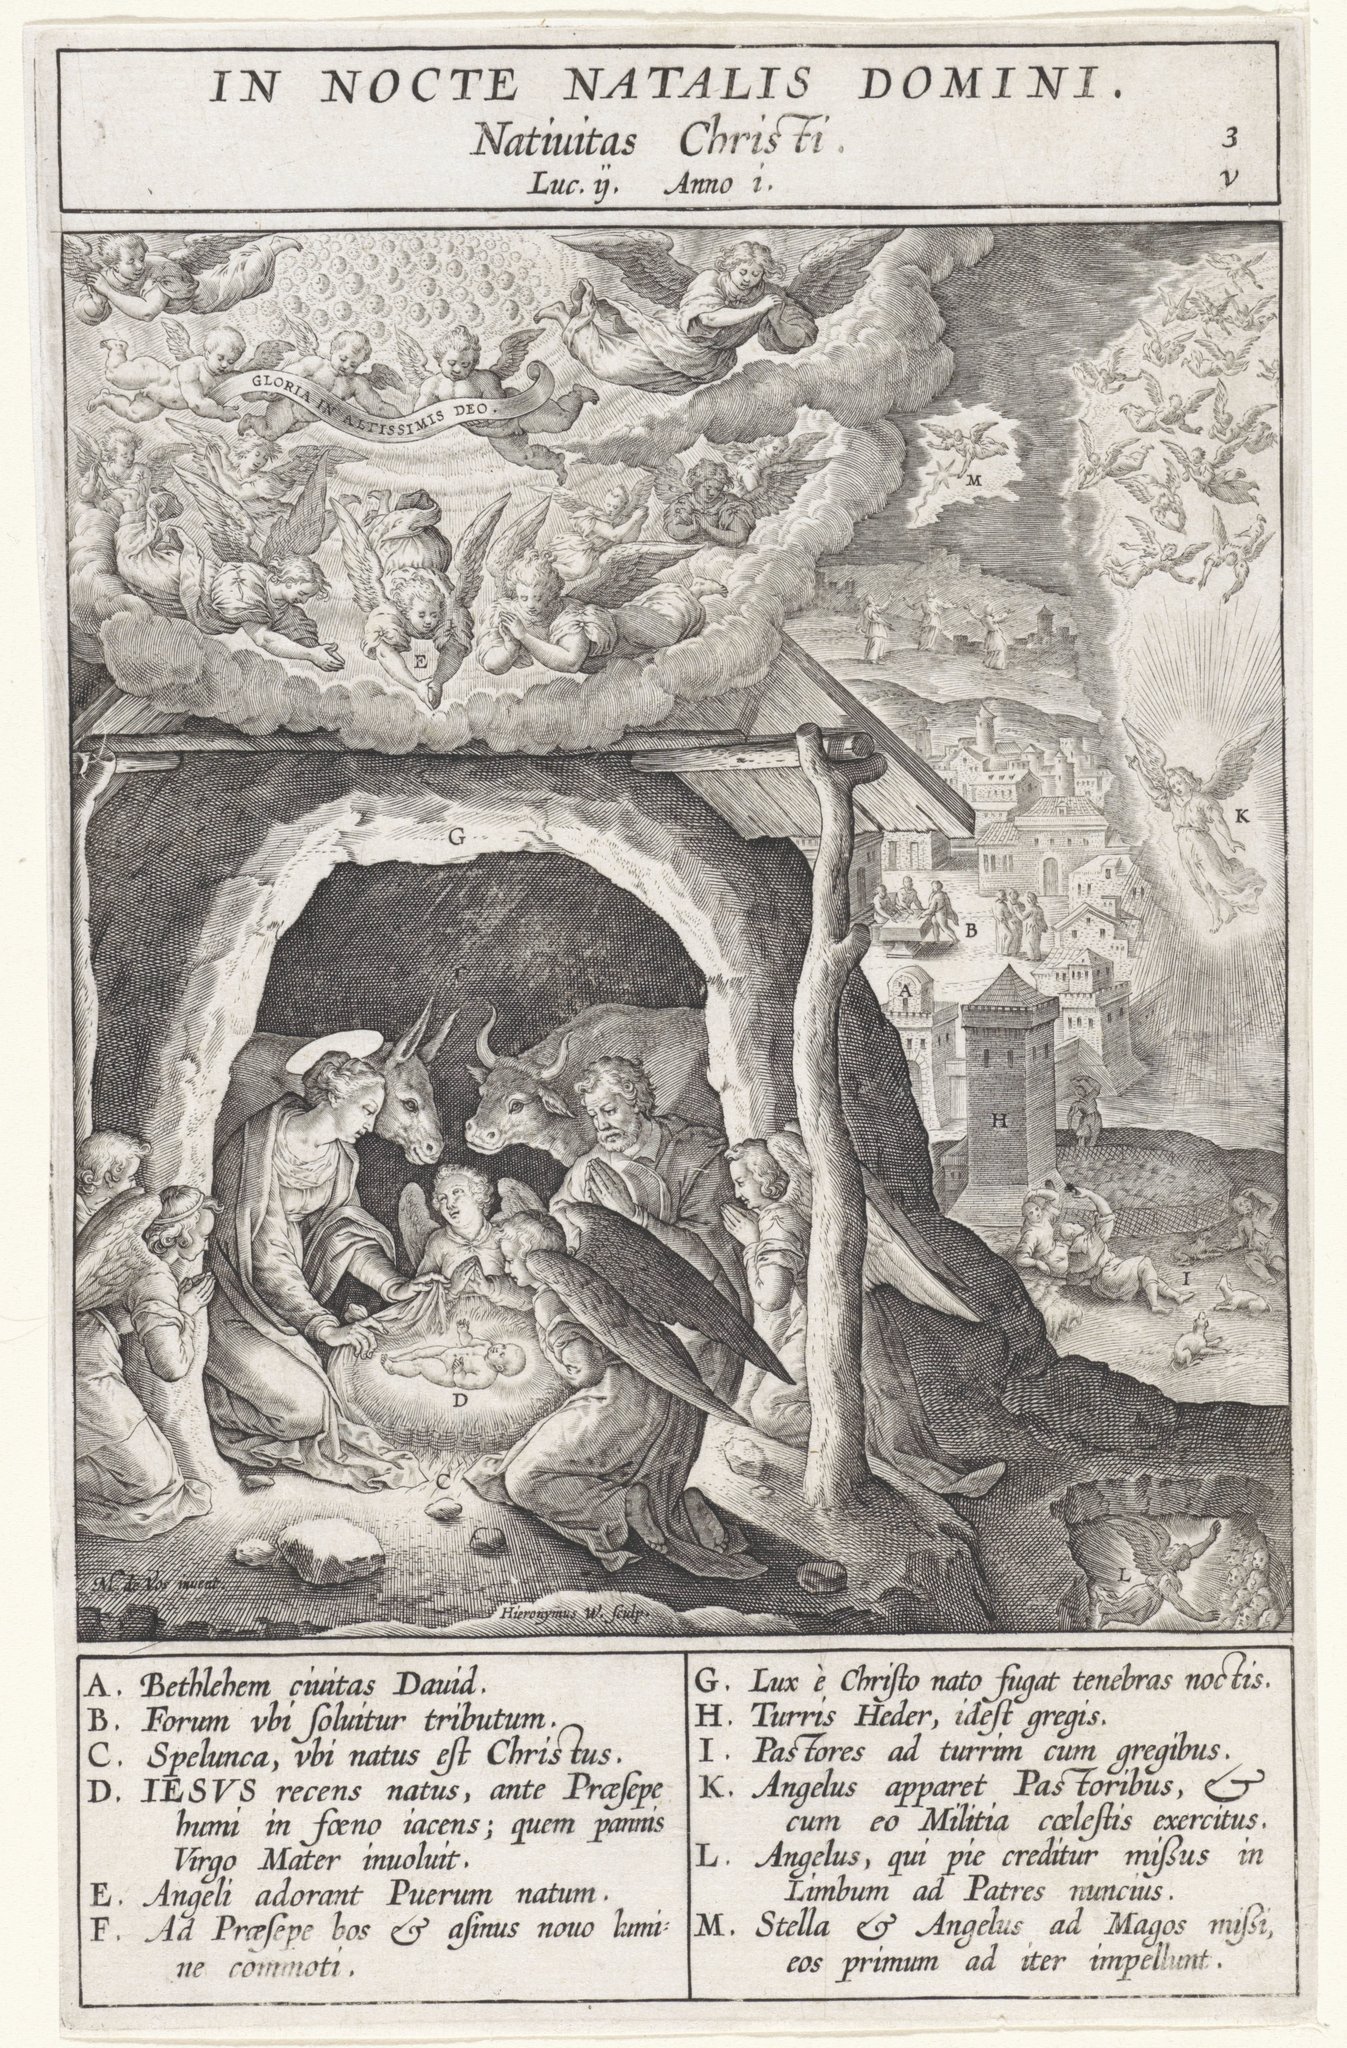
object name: print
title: Geboorte van Christus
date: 1593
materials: paper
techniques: engraving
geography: antwerp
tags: mary, joseph and the new-born christ (nativity) (+ angel(s) floating in the air), annunciation of christ's birth to the shepherds (and/or shepherdesses) at night; a host of singing angels in the air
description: Maria, Jozef en vier engelen knielen rond het Christuskind dat in zijn kribbe in de stal ligt. Andere engelen kijken toe vanuit de hemel. Op de achtergrond de aankondiging aan de herders. Bij verschillende elementen uit de voorstelling staan letters die corresponderen met de legenda in de marge.